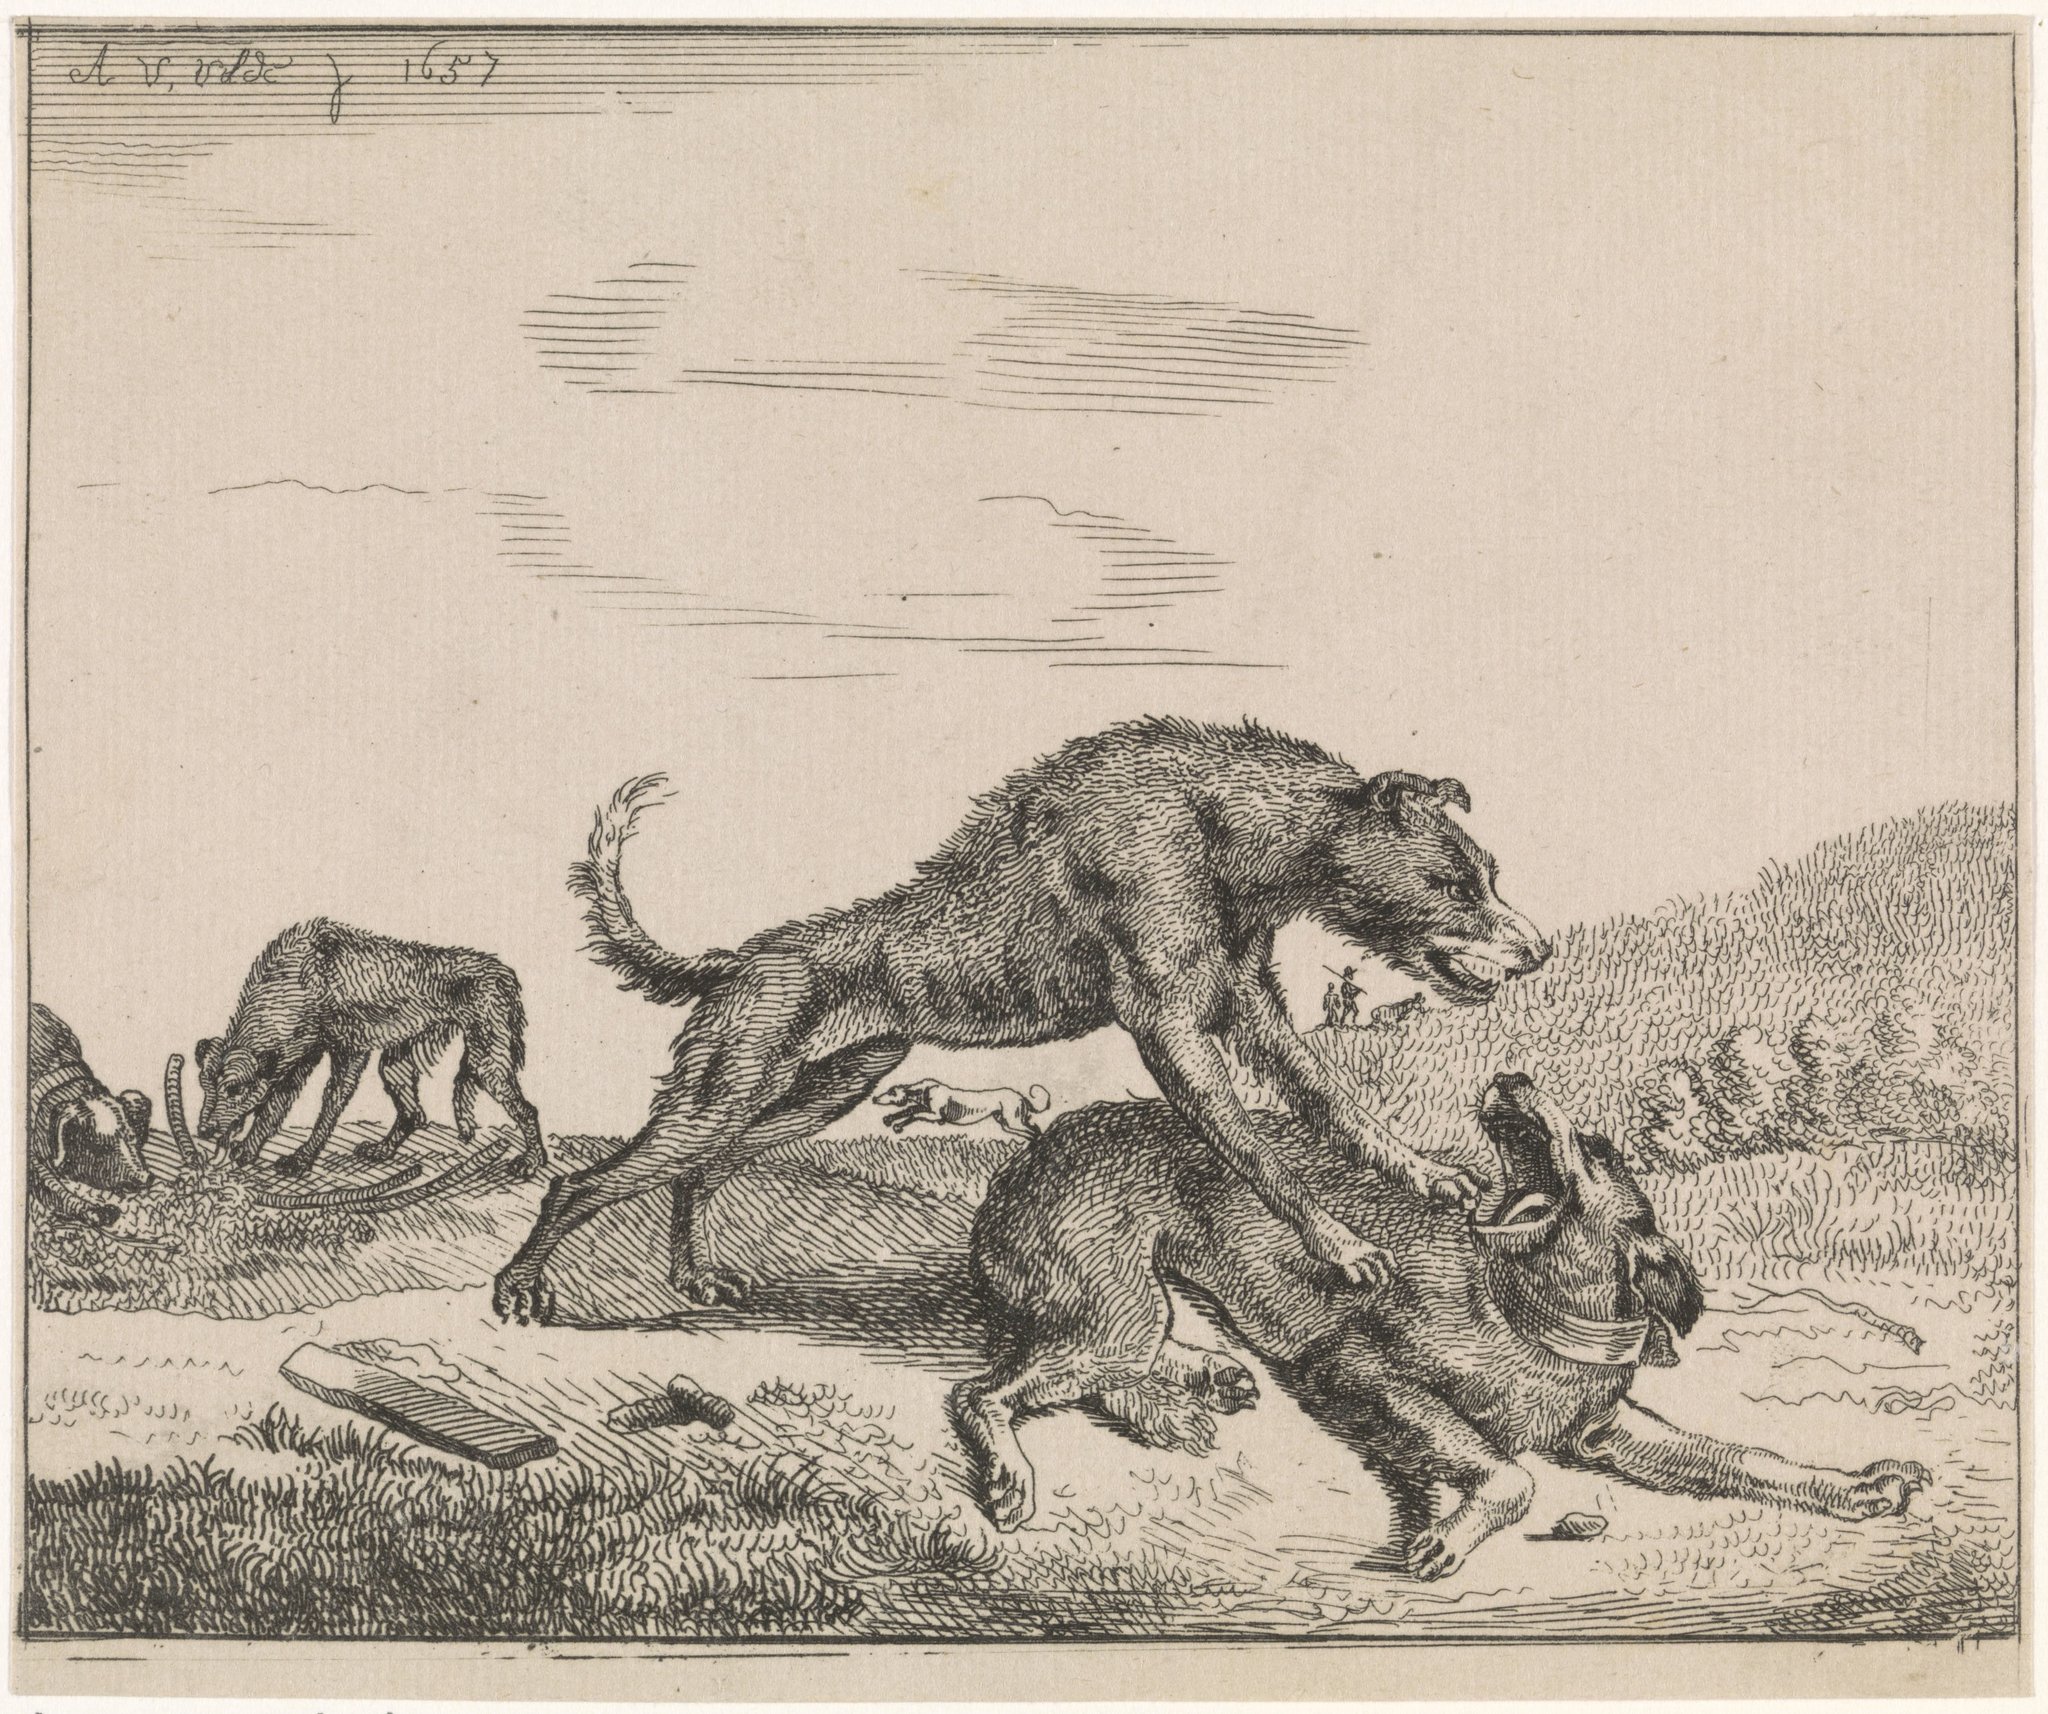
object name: print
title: Vechtende honden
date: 1657-1707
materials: paper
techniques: etching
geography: northern netherlands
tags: dog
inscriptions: collector's mark: Lugt 2228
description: Kopie van de prent uit de serie van Adriaen van de Velde.